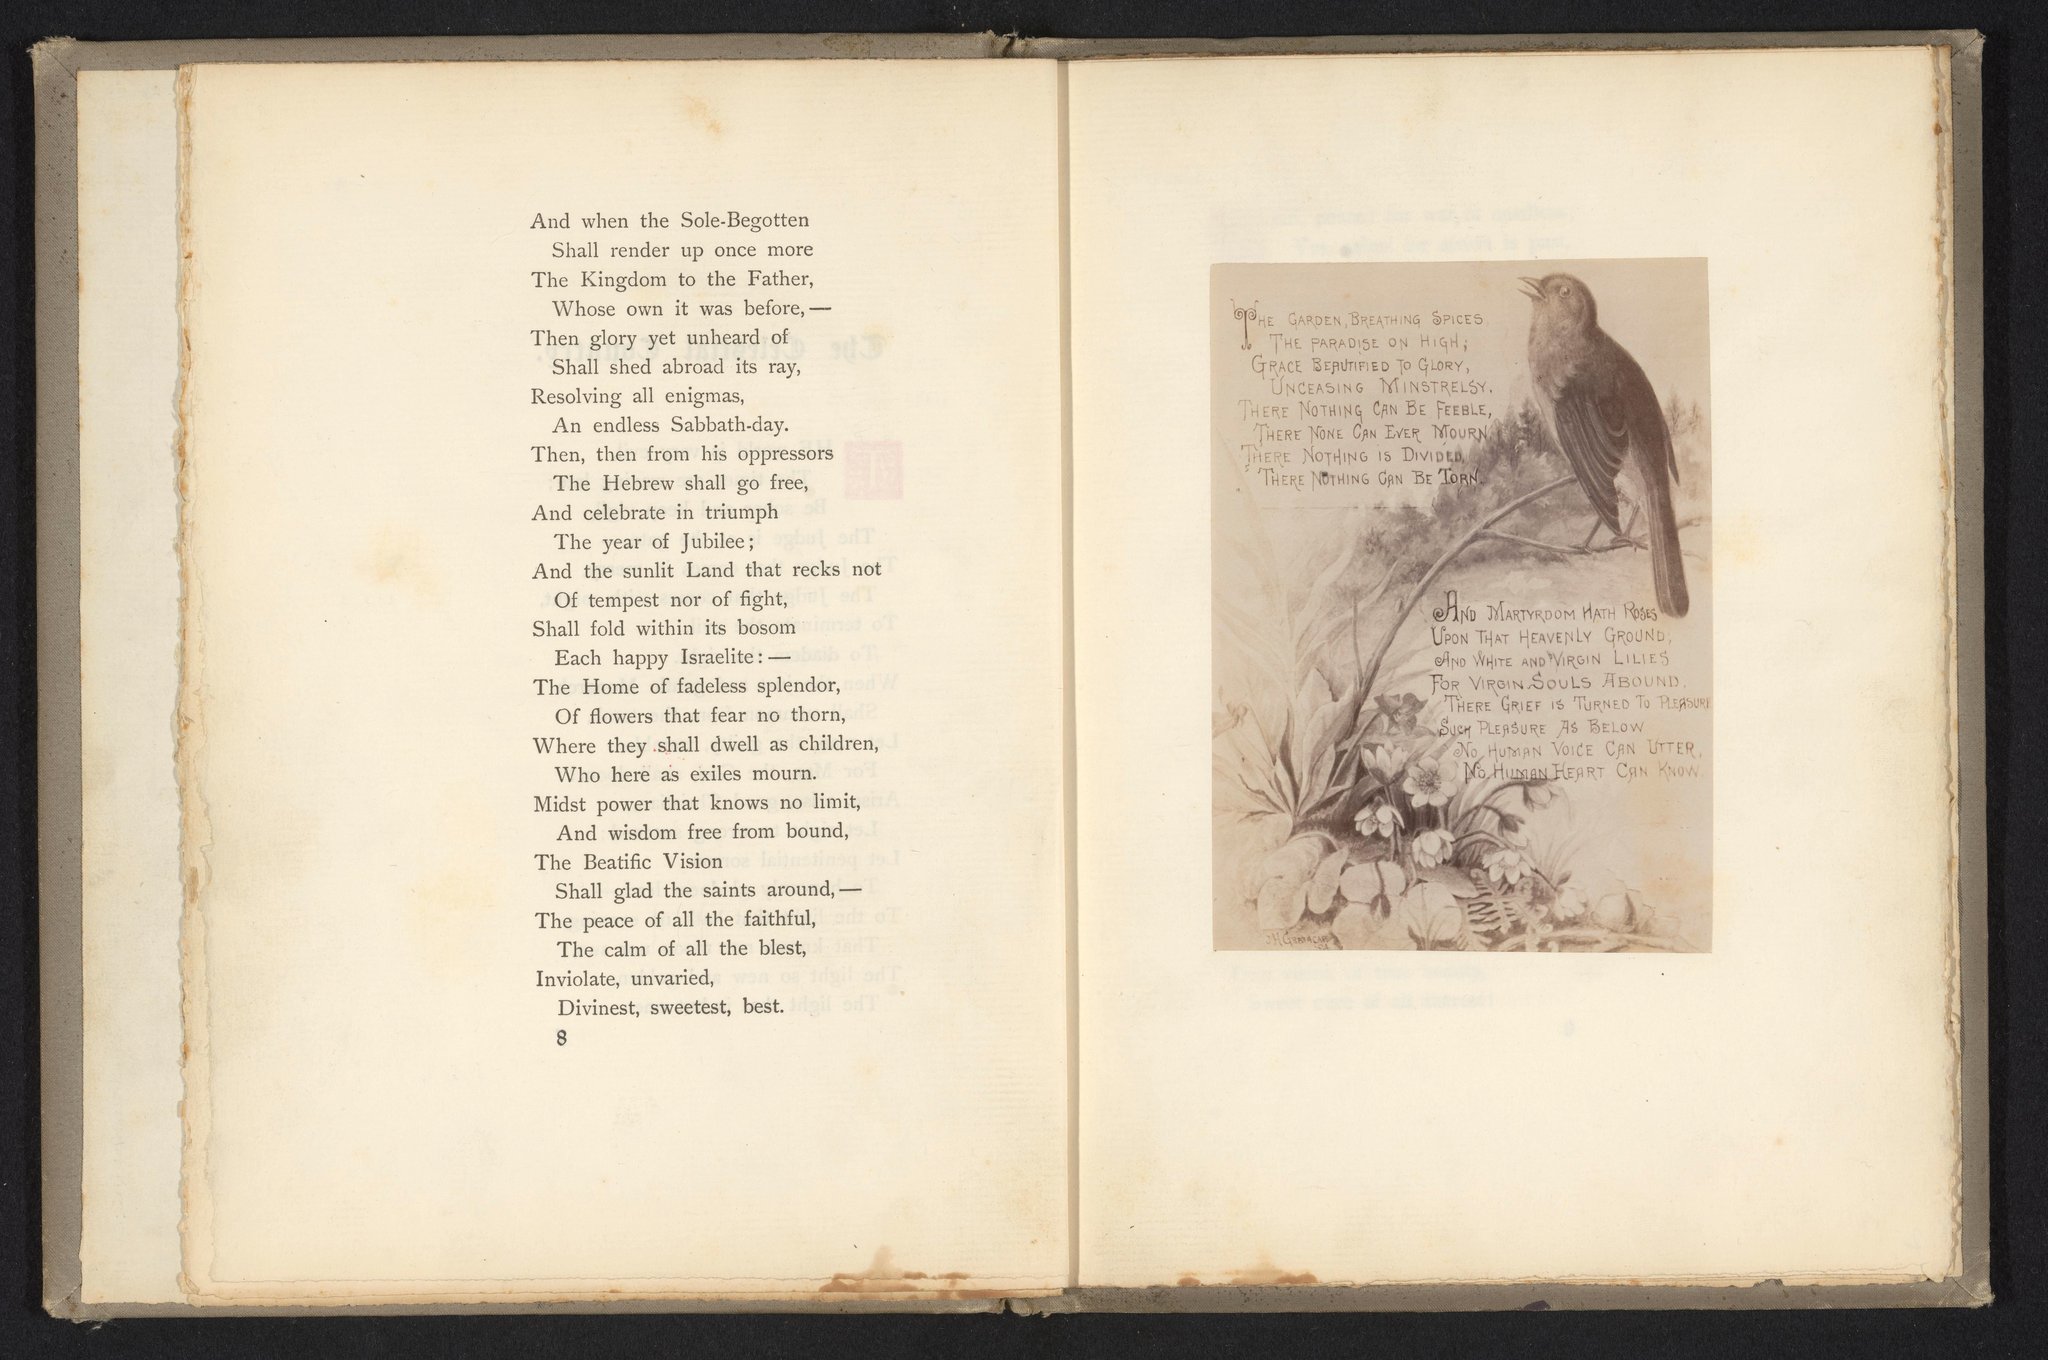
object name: page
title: Fotoreproductie van een vers van het gedicht The celestial country met afbeeldingen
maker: Anonymous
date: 1884-1885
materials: photographic support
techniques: albumen print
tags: birds, handwriting, written text